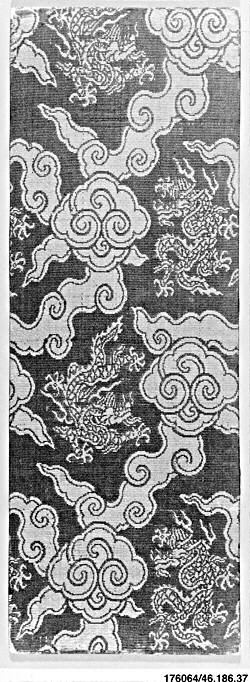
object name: sutra cover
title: Sutra cover with dragons amid clouds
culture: chinese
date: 1501-1600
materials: textile, silk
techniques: patterning, weave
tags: dragons,clouds